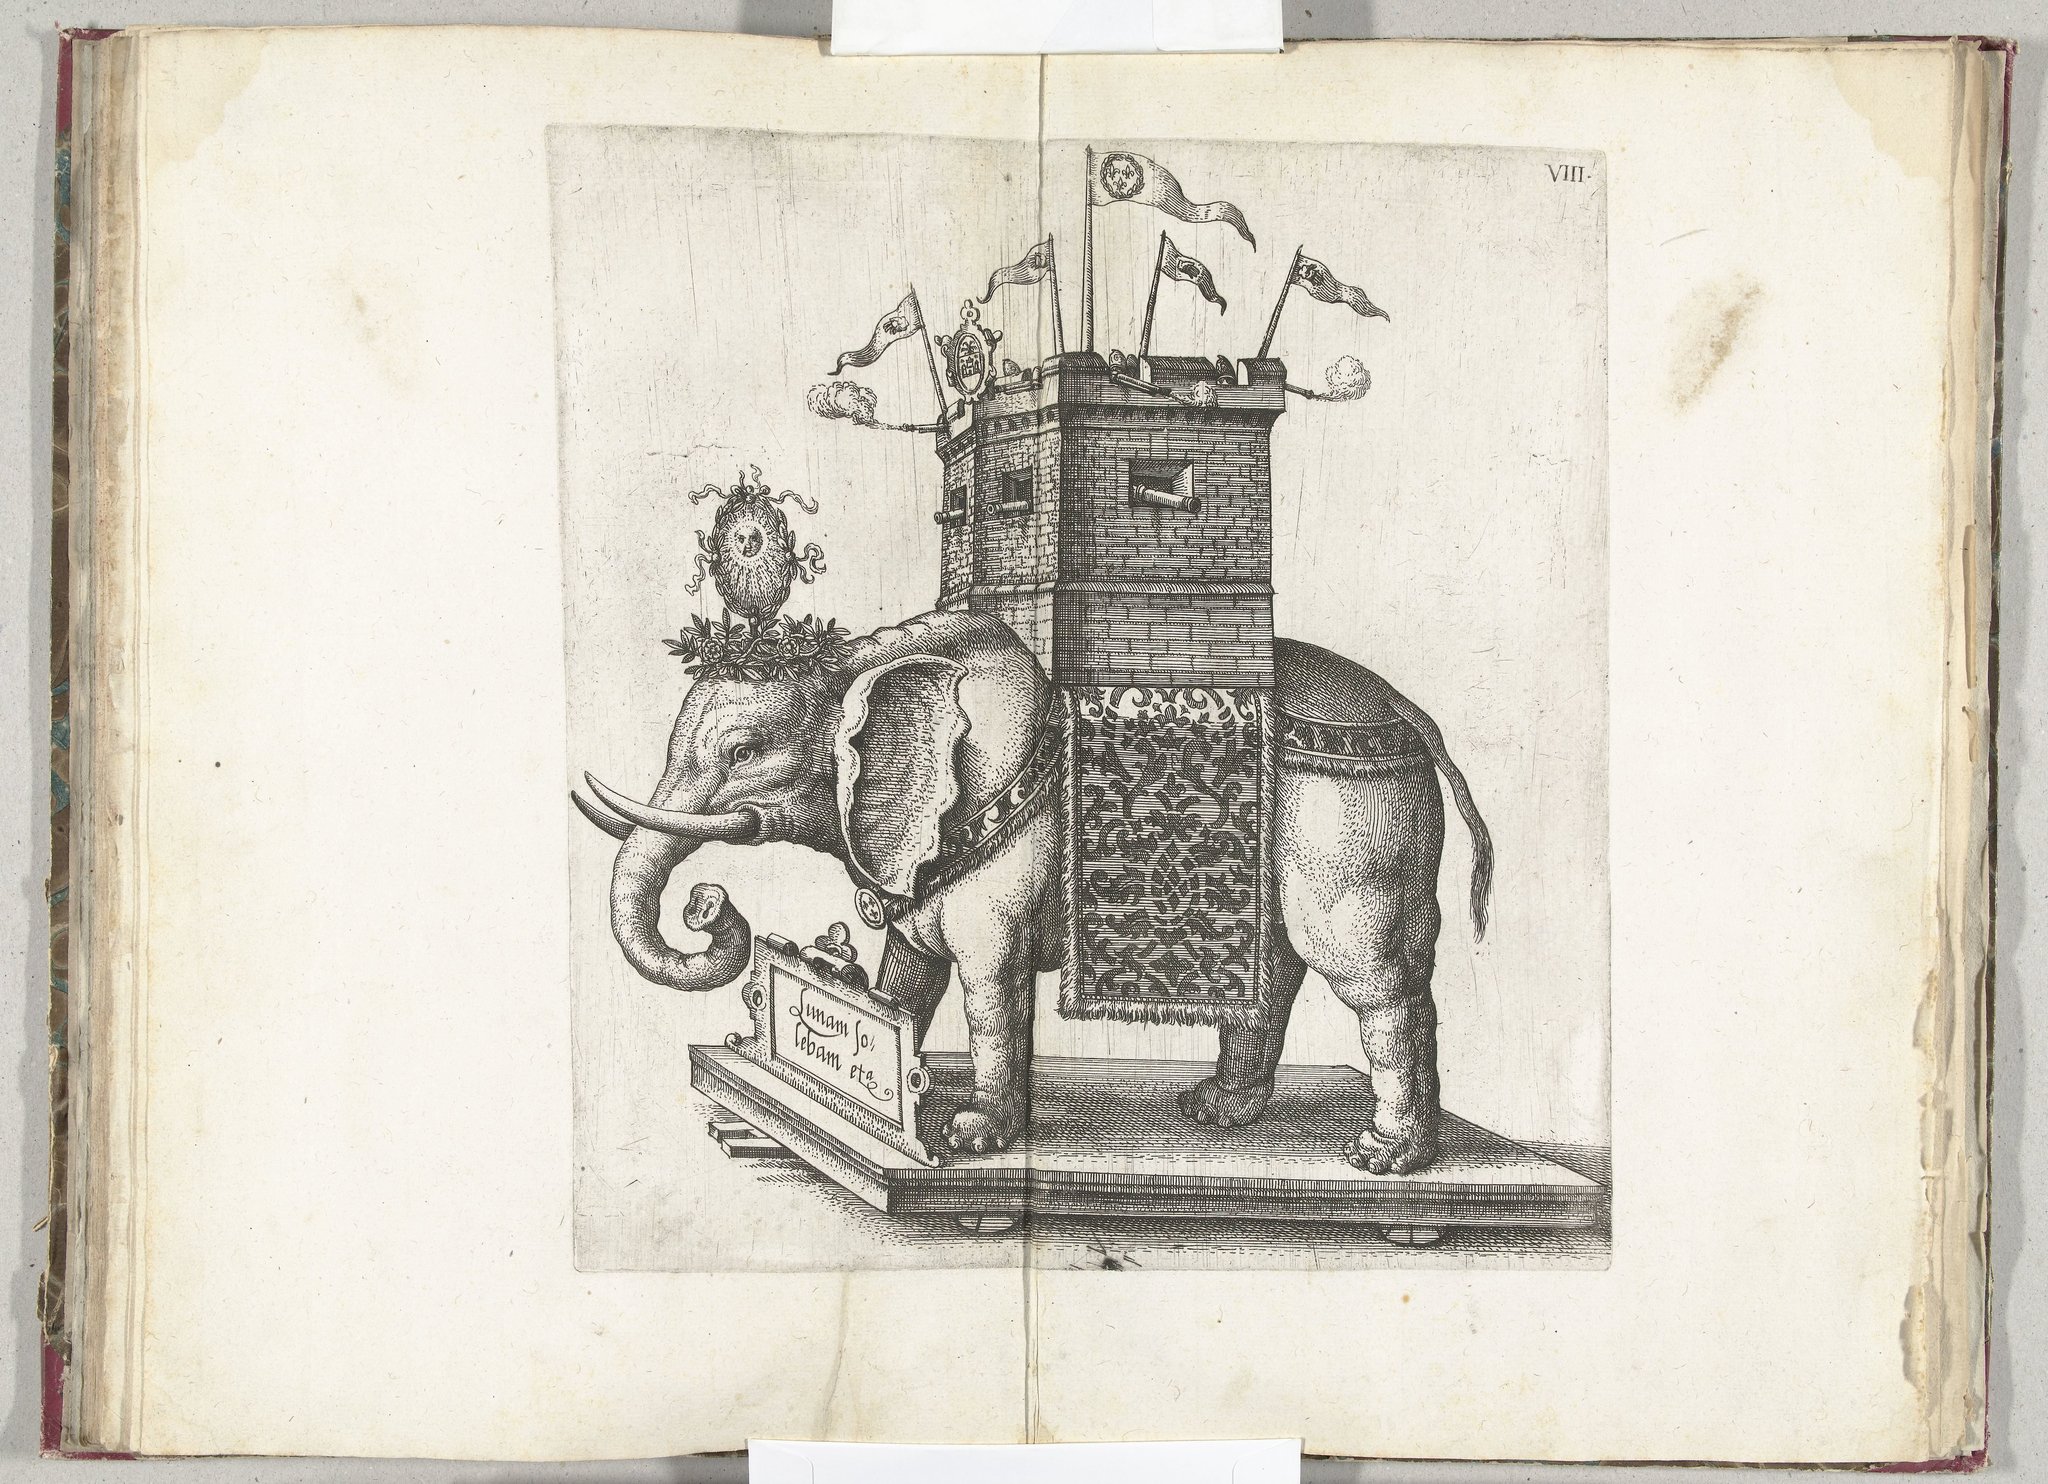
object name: print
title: Praalwagen met de olifant, 1582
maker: Anonymous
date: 1582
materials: paper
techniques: etching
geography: netherlands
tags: paris, françois-hercule de valois (hertog van anjou), float ~ triumph, triumphal entry and public reception, pageant, 'entrée solennelle', 'joyeuse entrée', warfare; military affairs (+ mounted troops on other animals than horses), trunked animals: elephant, antwerp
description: Illustratie in: La ioyeuse et magnifique entrée de Françoys ... Duc de Brabant, d'Anjou, Alençon, Berri et c. en sa tres-renommée ville d'Anvers, Christoffel Plantijn, Antwerpen 1582, pl. VIII. Boek in de Rijksmuseum Research Library met signatuur: 327 I 8.